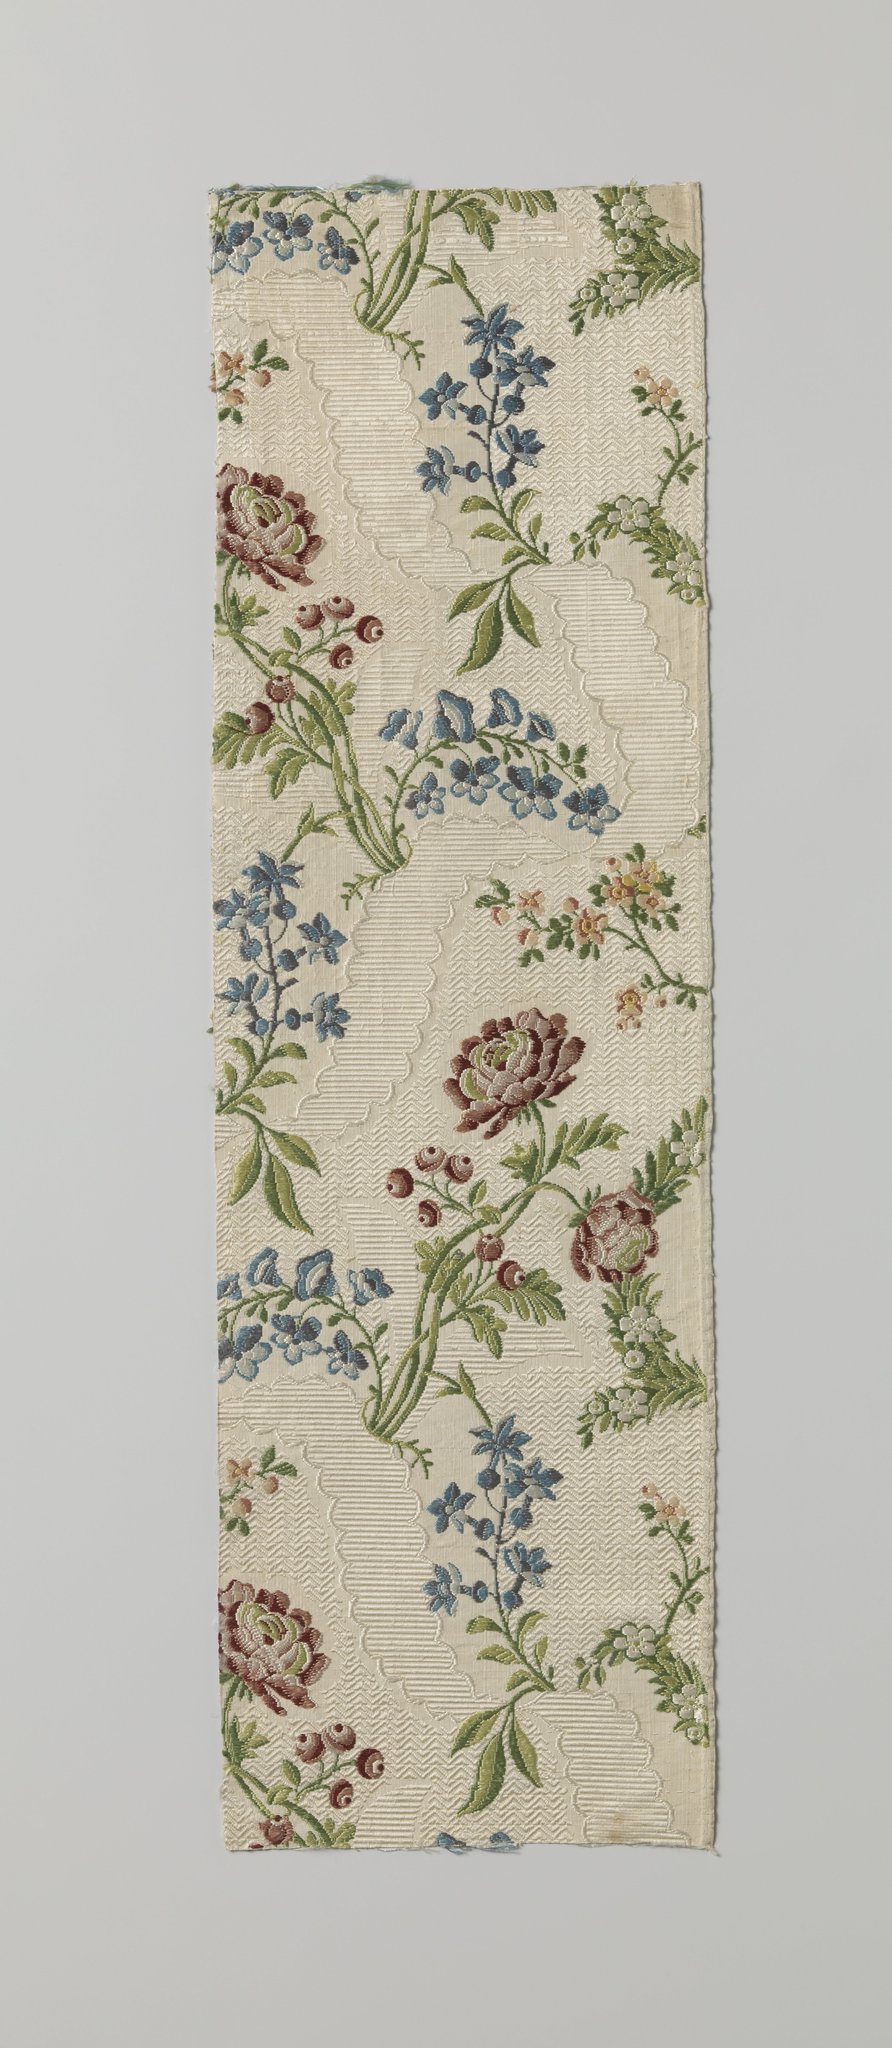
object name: fragment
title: Fragment veelkleurige gebrocheerde zijde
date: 1700-1760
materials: silk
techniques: brocade, gadrooning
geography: netherlands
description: Fragment veelkleurig zijdeweefsel. De witte grond heeft golvende, gelobde banden en velden met een fijn gestreept of een zig-zag patroon. Op het witte patroon heeft het patroon veelkleurige bloemtakken met kleine blauwe, roze en witte bloemen en grote rode bloemen.